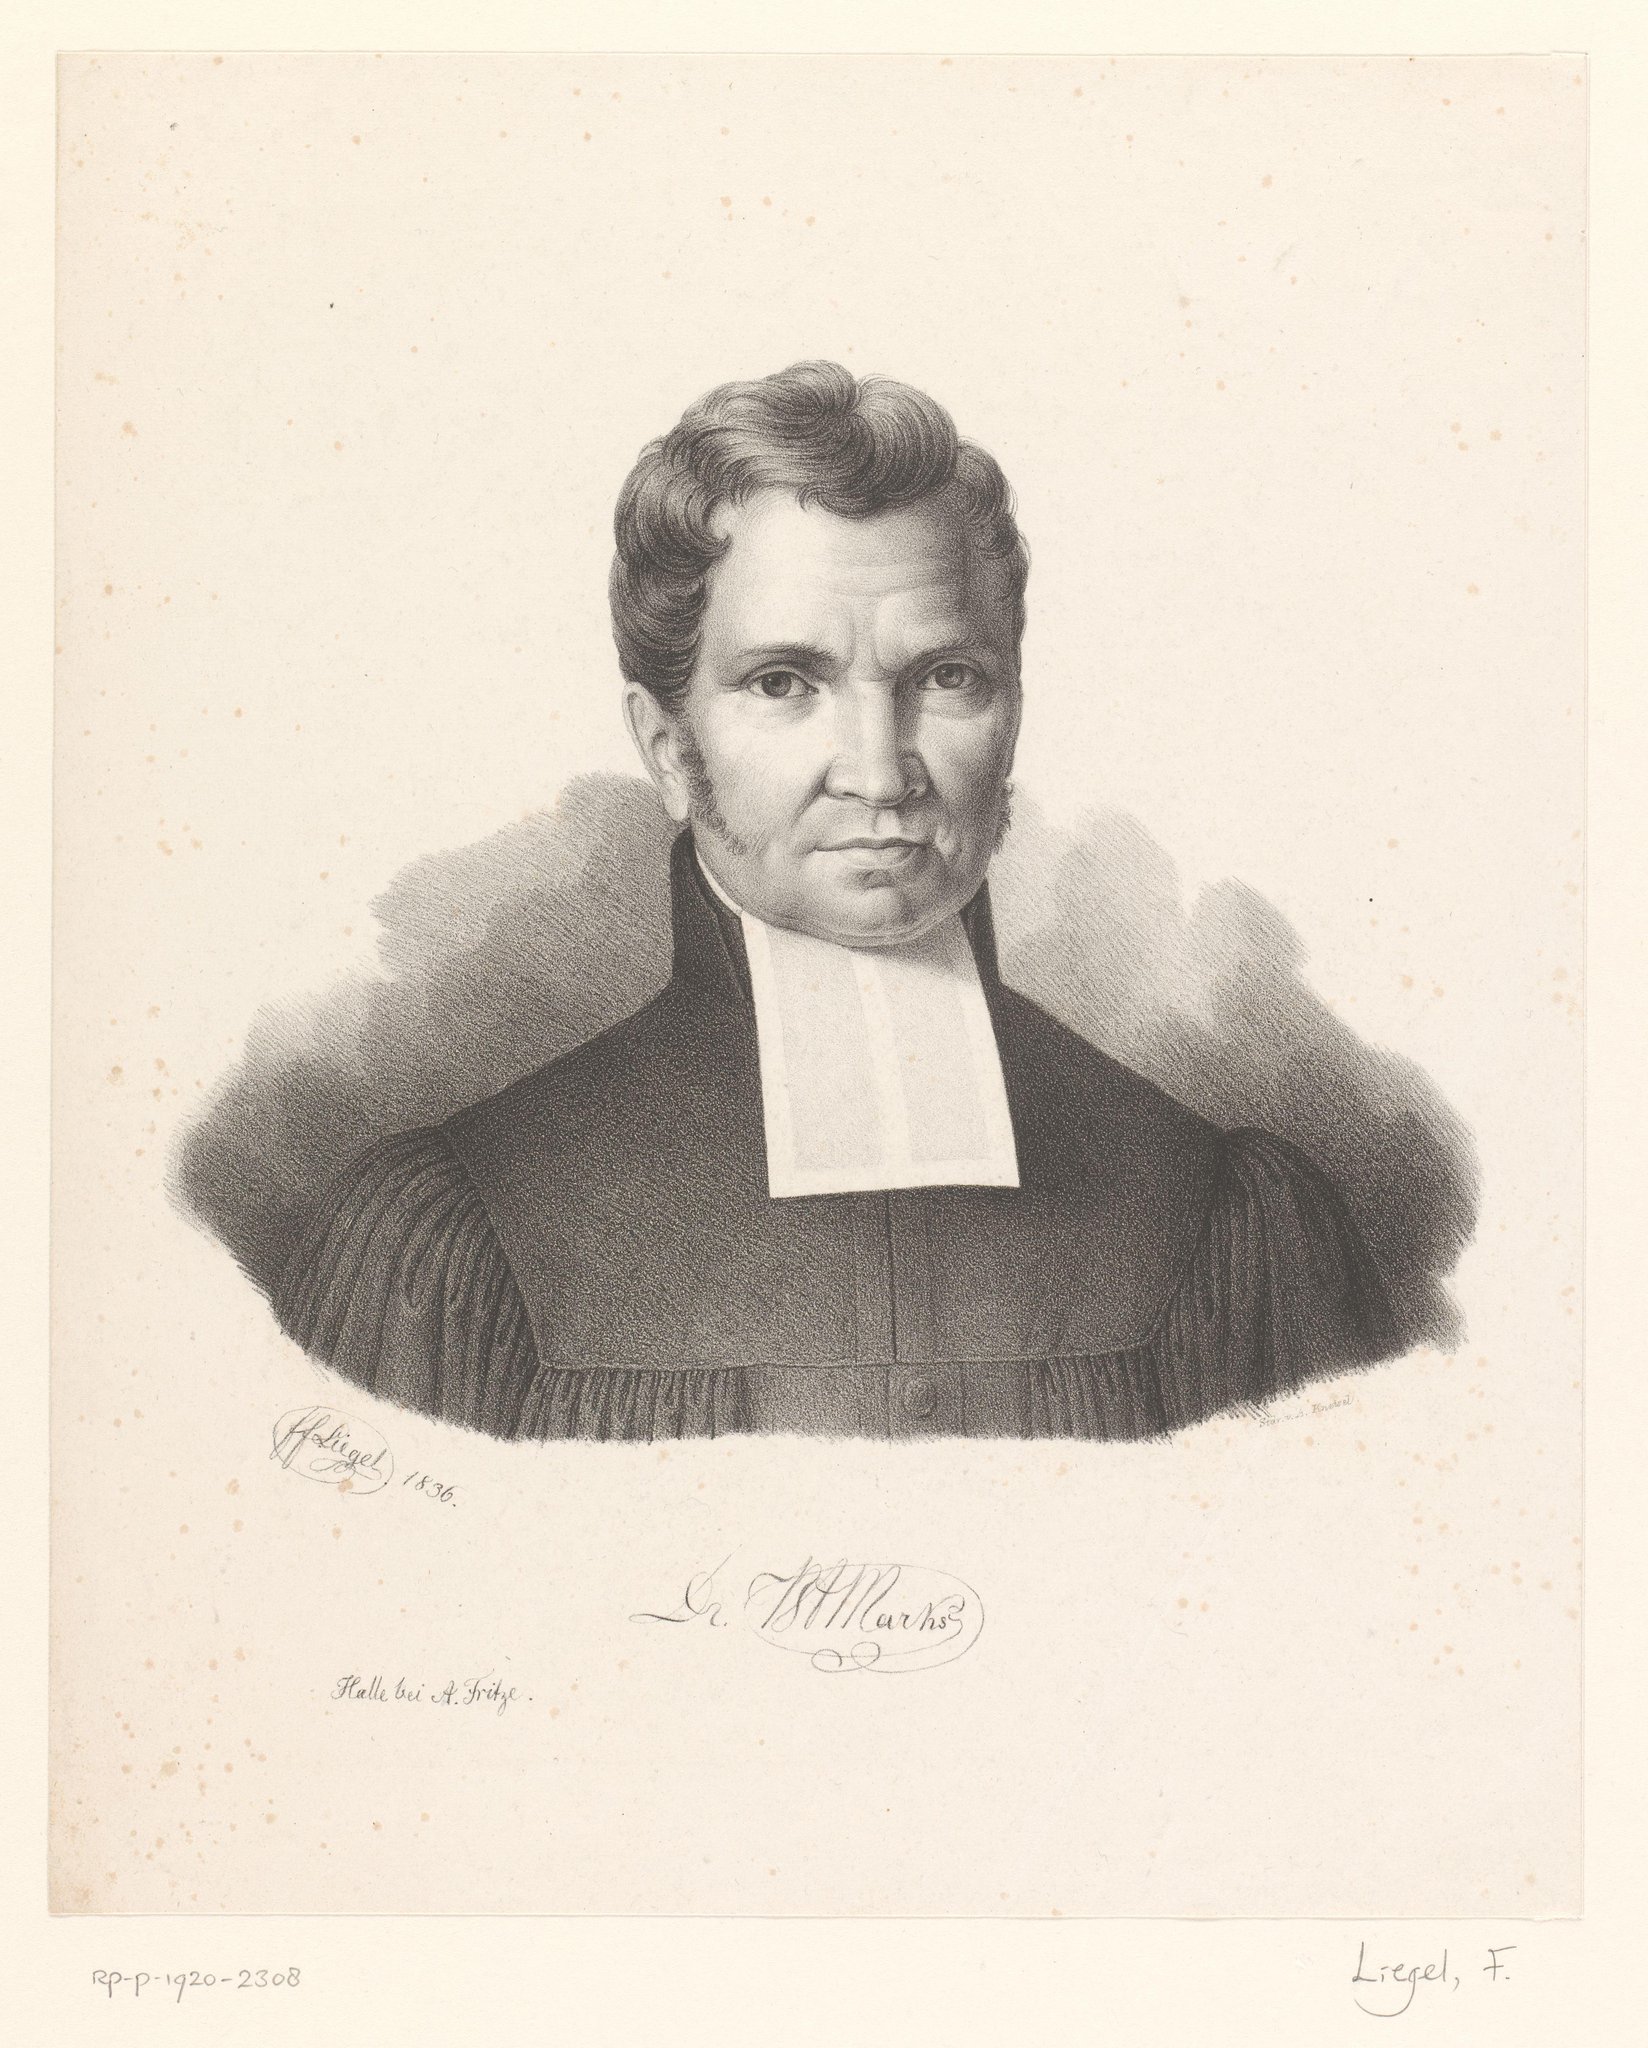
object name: print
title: Portret van Johan Casimir van Palts-Lautern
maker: Anonymous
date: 1600-1699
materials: paper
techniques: engraving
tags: historical persons, ruler, sovereign